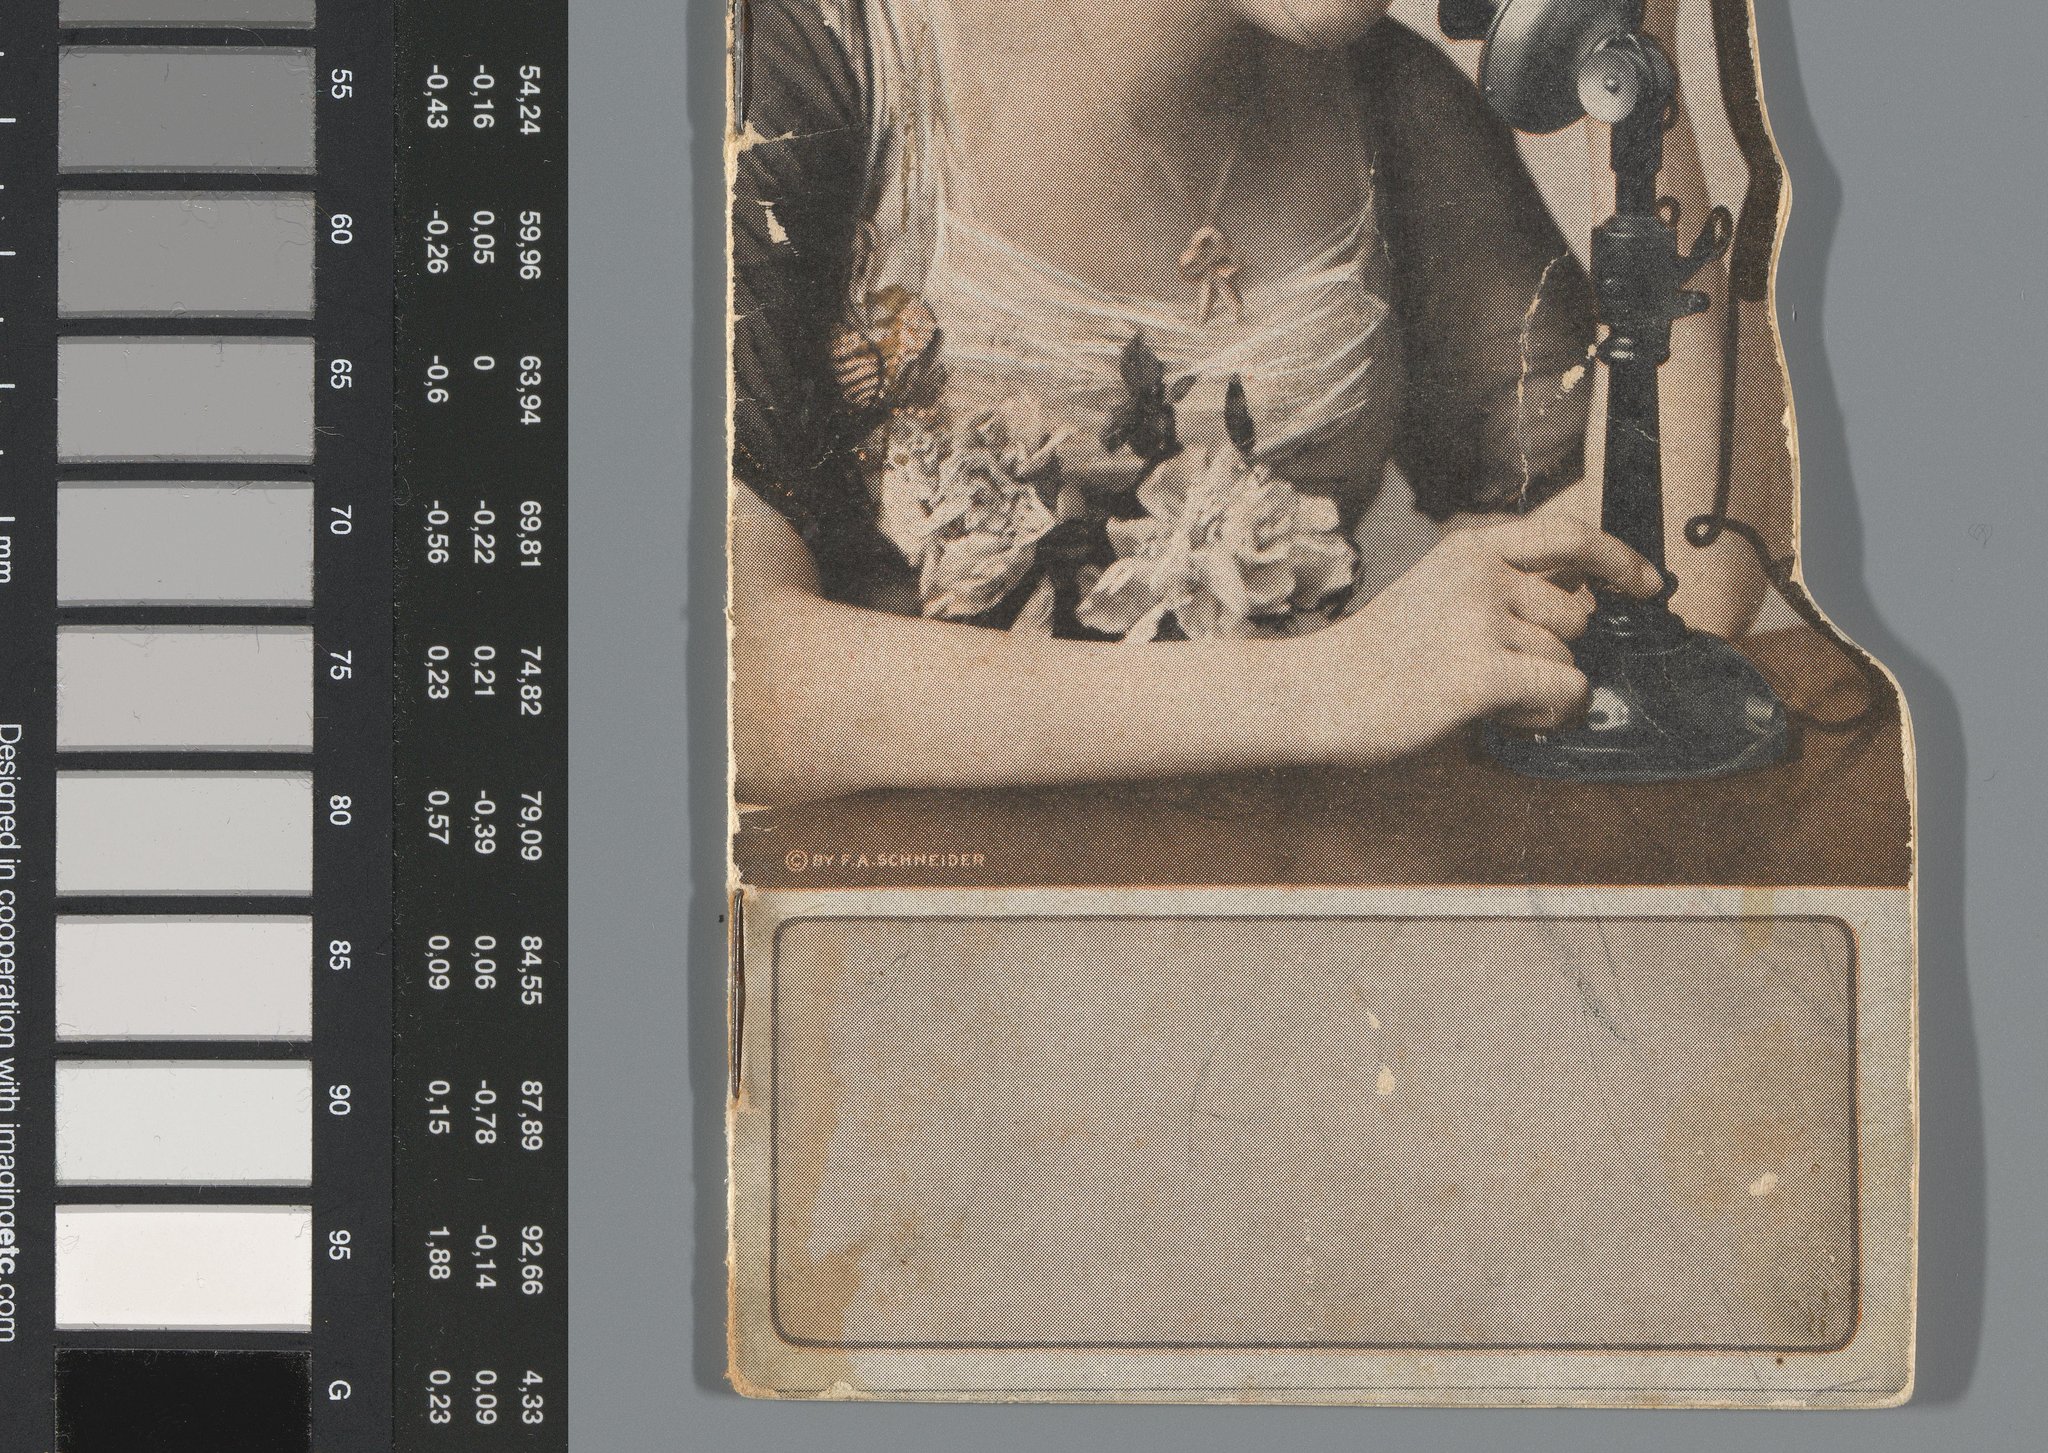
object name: photograph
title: Hello-Book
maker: f.a. schneider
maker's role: fotograaf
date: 1900-1915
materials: paper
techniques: autotype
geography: united states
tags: united states of america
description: Telepohone directory met portret van een vrouw aan de telefoon en een advertentie voor Millar’s Coffees op de achterkant.